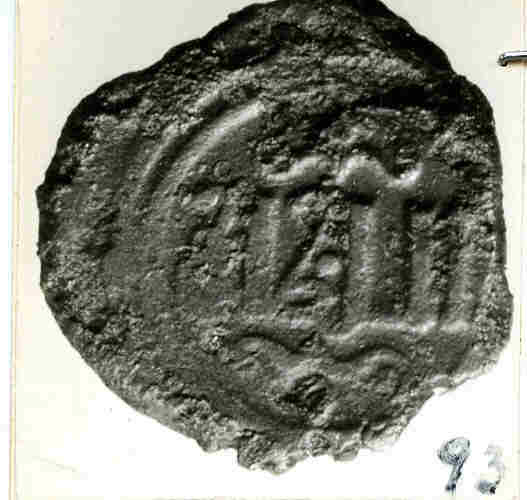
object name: coin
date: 1167-1233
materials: copper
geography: iran